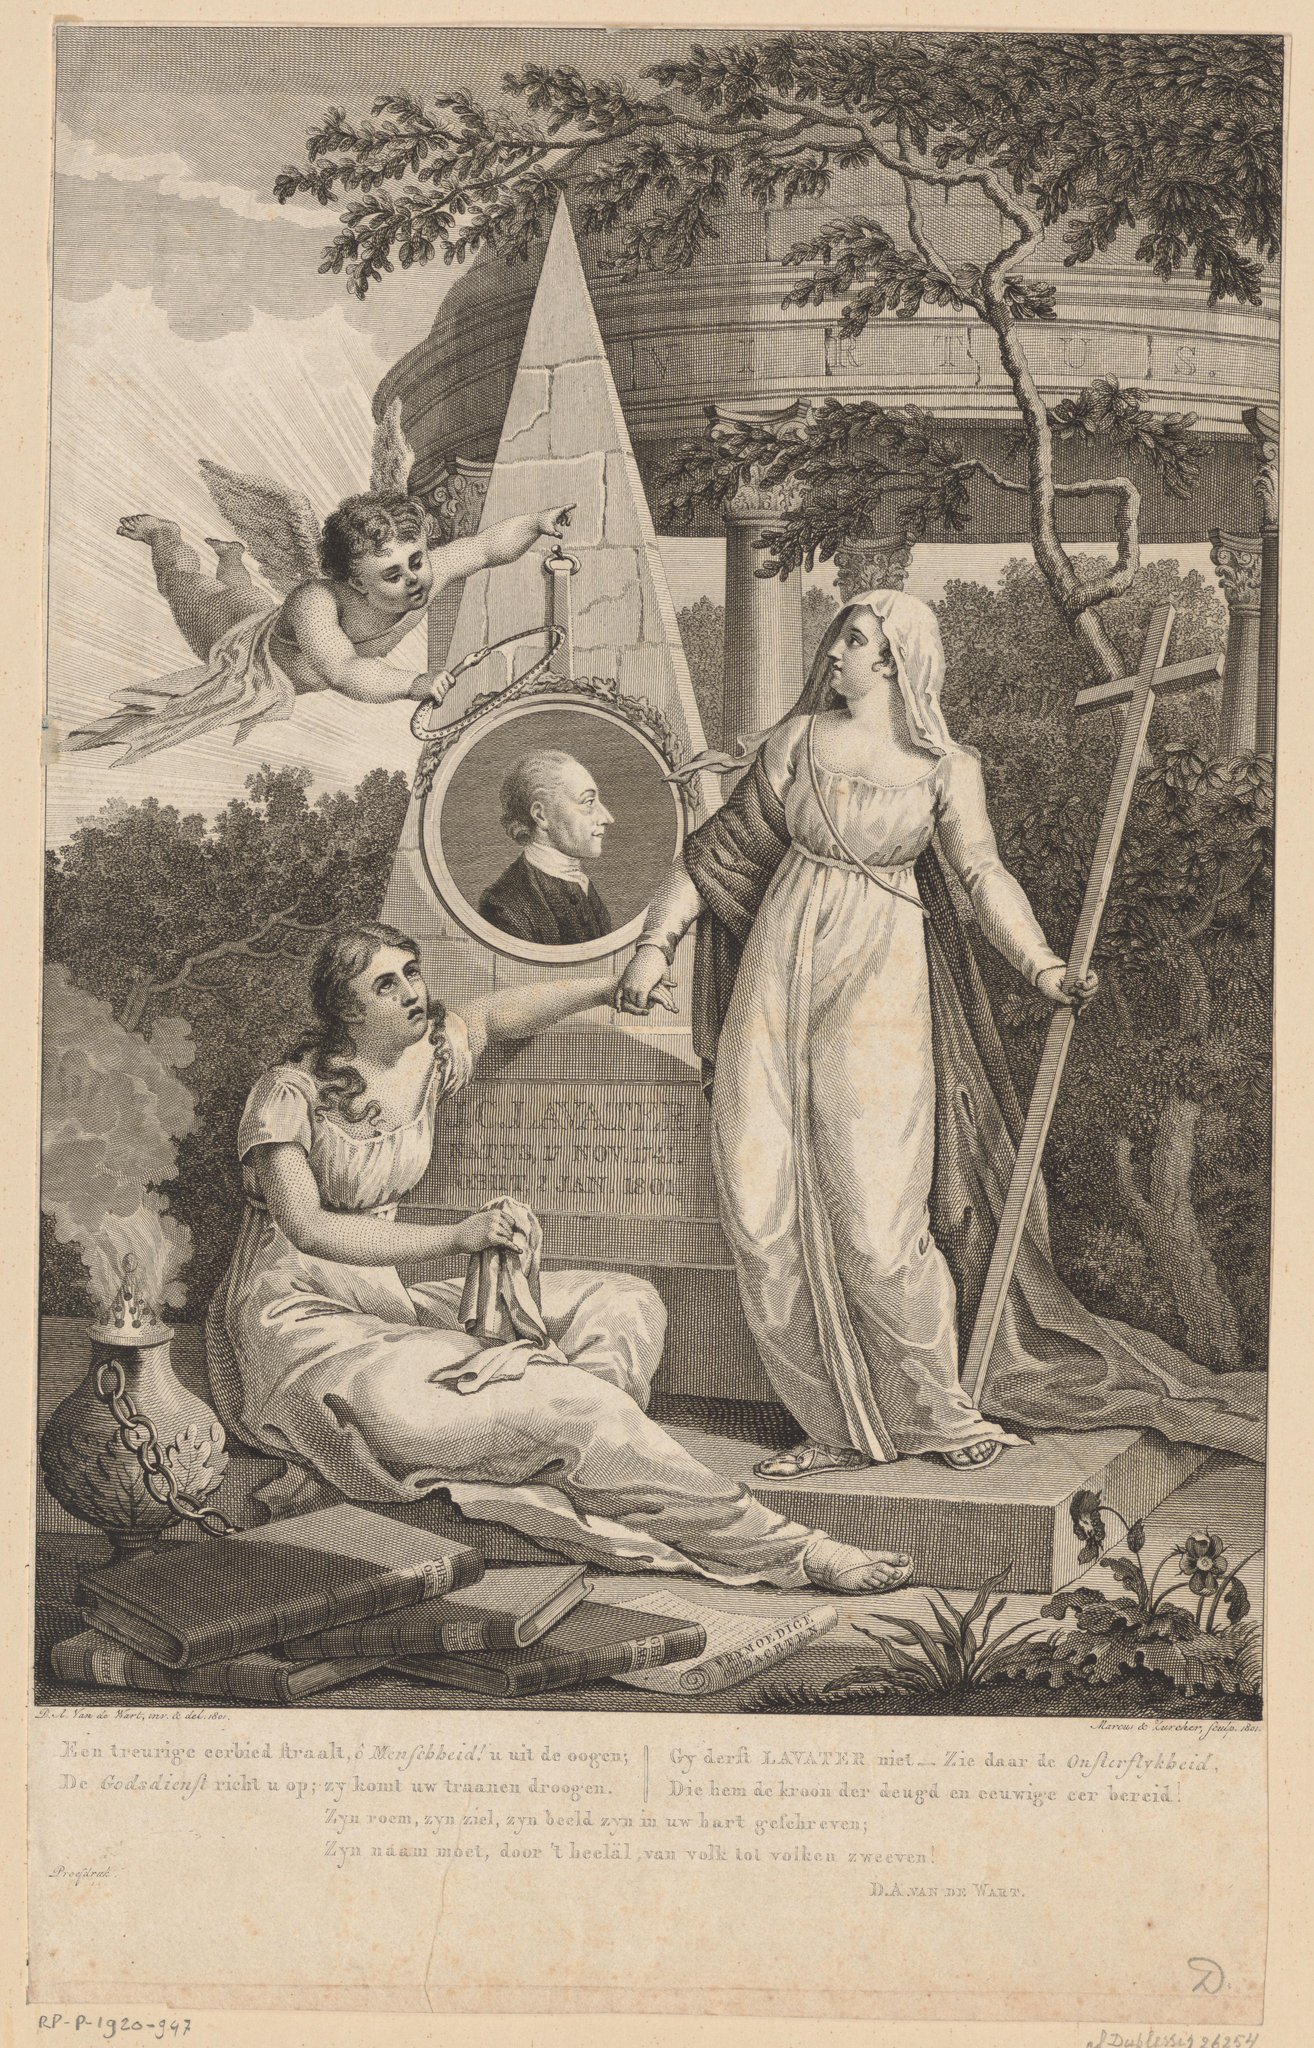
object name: print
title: Grafmonument met het portret van Johann Caspar Lavater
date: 1801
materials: paper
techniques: engraving, etching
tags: johann caspar lavater, landscapes, theologian, historical persons, grave-building, monumental tomb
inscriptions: collector's mark: Lugt 2228, inscription: ‘D’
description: Grafmonument met portret van de Zwitserse theoloog Johann Kaspar Lavater. Twee vrouwen in antieke gewaden treuren bij een tombe in een landschap. Volgens het lofdicht onder de voorstelling zijn dit de personificaties van de Mensheid (rechts) en de Godsdienst (links). Op de achtergrond een koepel waarop het woord: Virtus. Linksboven het grafmonument zweeft een putto die de onsterfelijkheid voorstelt. In zijn hand een ouroboros, een slang die in zijn eigen staart bijt, als mythisch symbool voor de eeuwigheid.